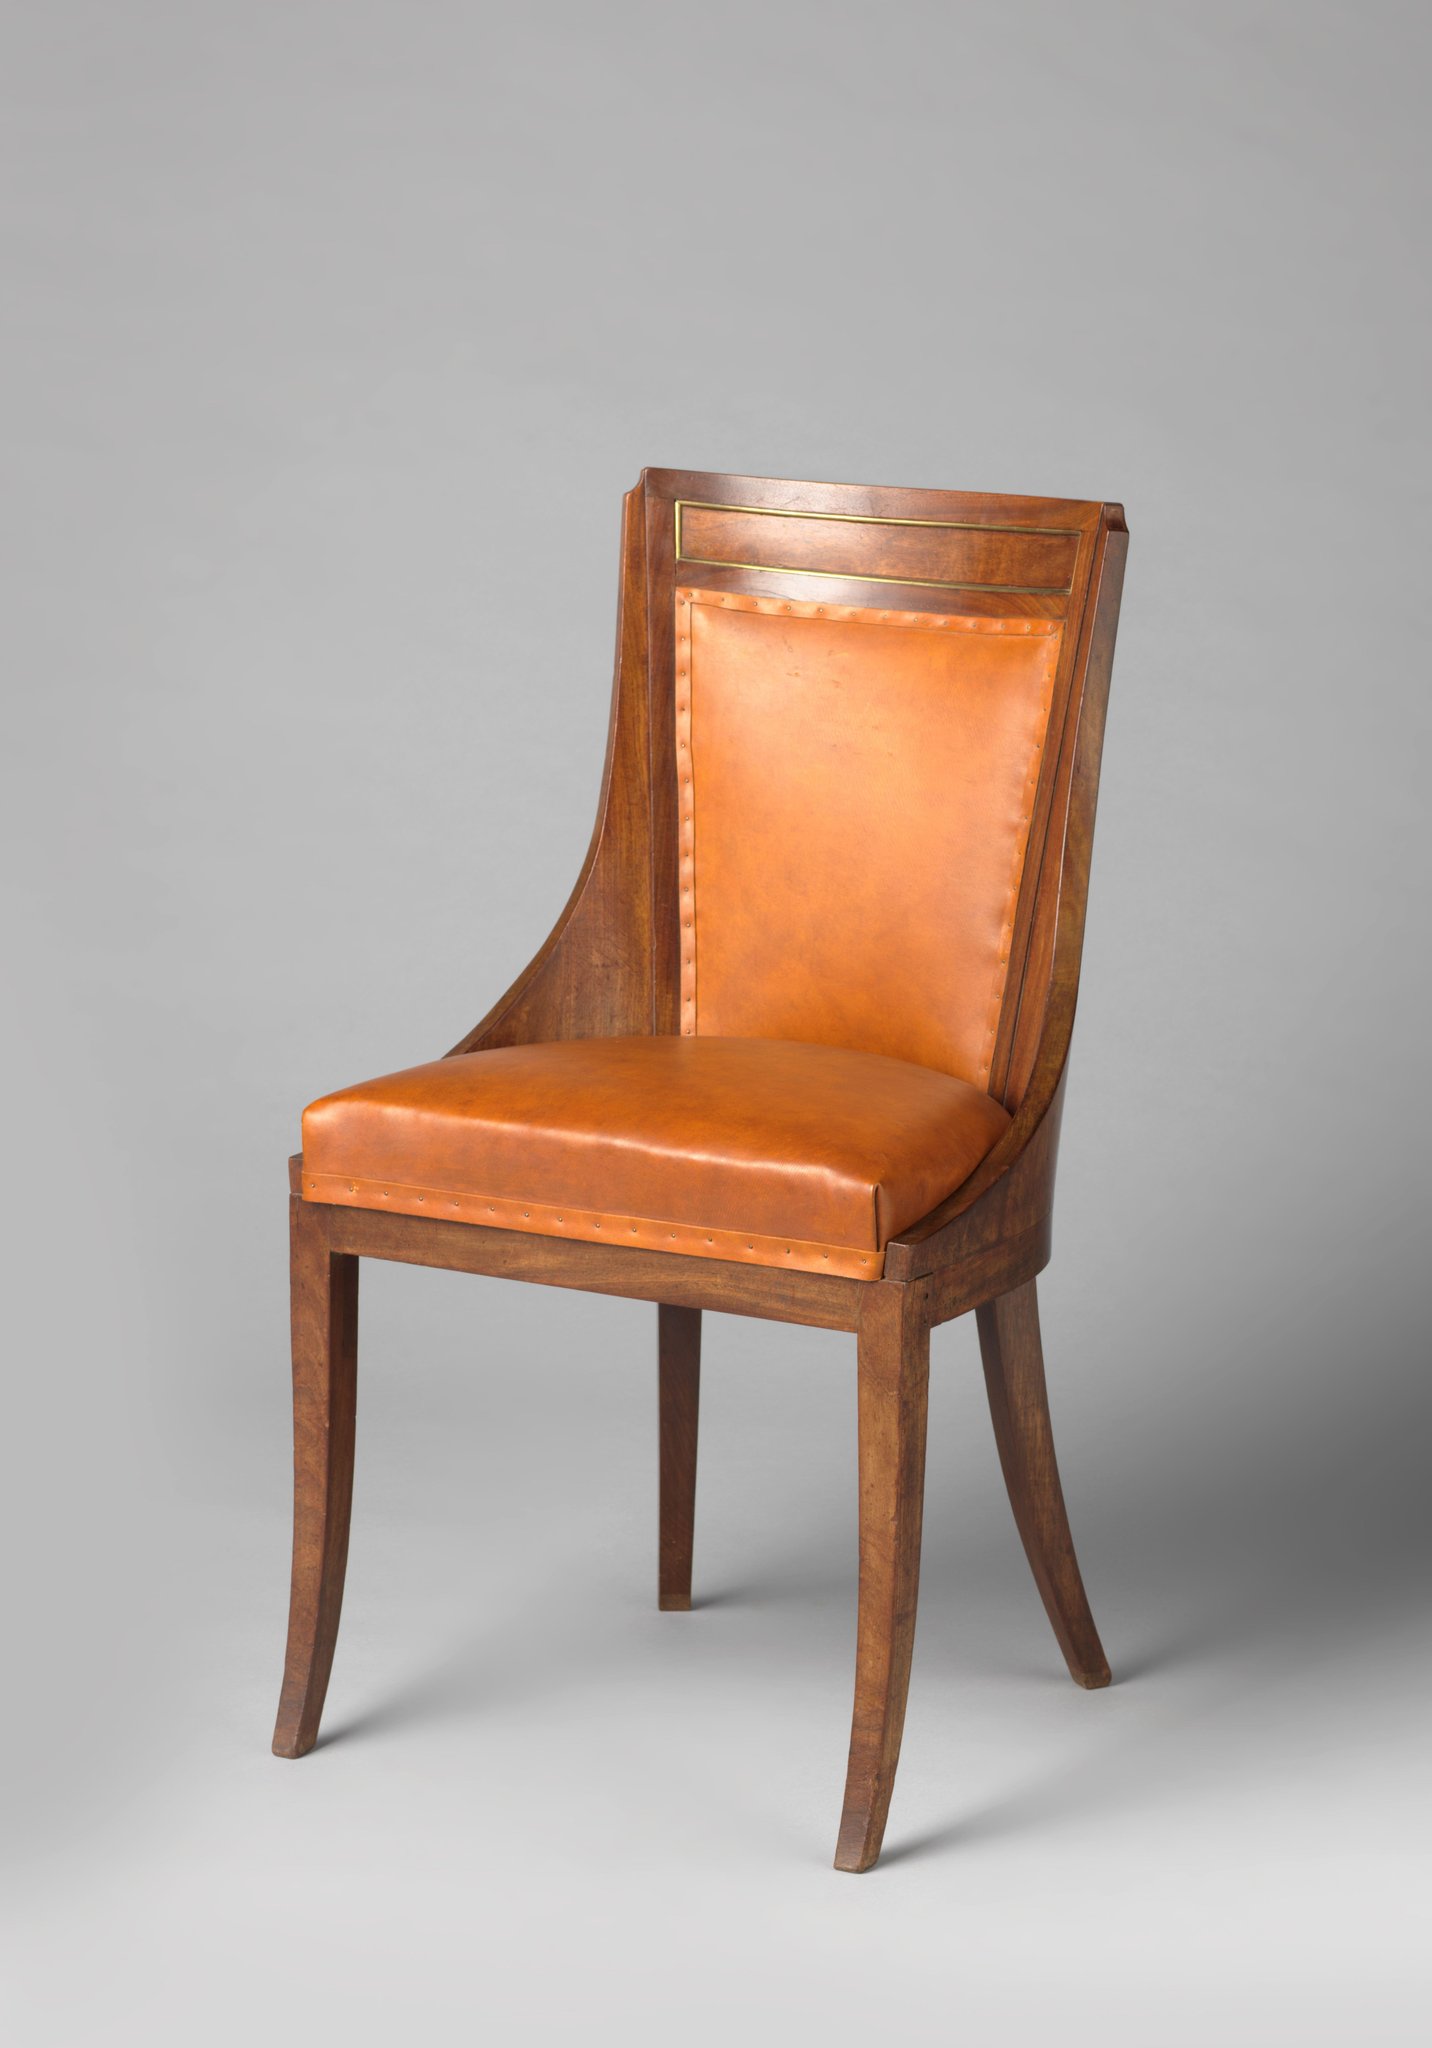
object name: chair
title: Stoel van mahoniehout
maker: Anonymous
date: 1825-1850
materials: wood, leather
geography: netherlands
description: Stoel van mahoniehout met flauw gebogen rug op vier rechthoekige, enigszins uitstaande poten. Losse met geel rundsleder beklede zitting en met leder bespannen rug. Dit leer is aangebracht voor 1907, vroeger was de stoel met haardoek bekleed (zie cat.1913 no. 238).